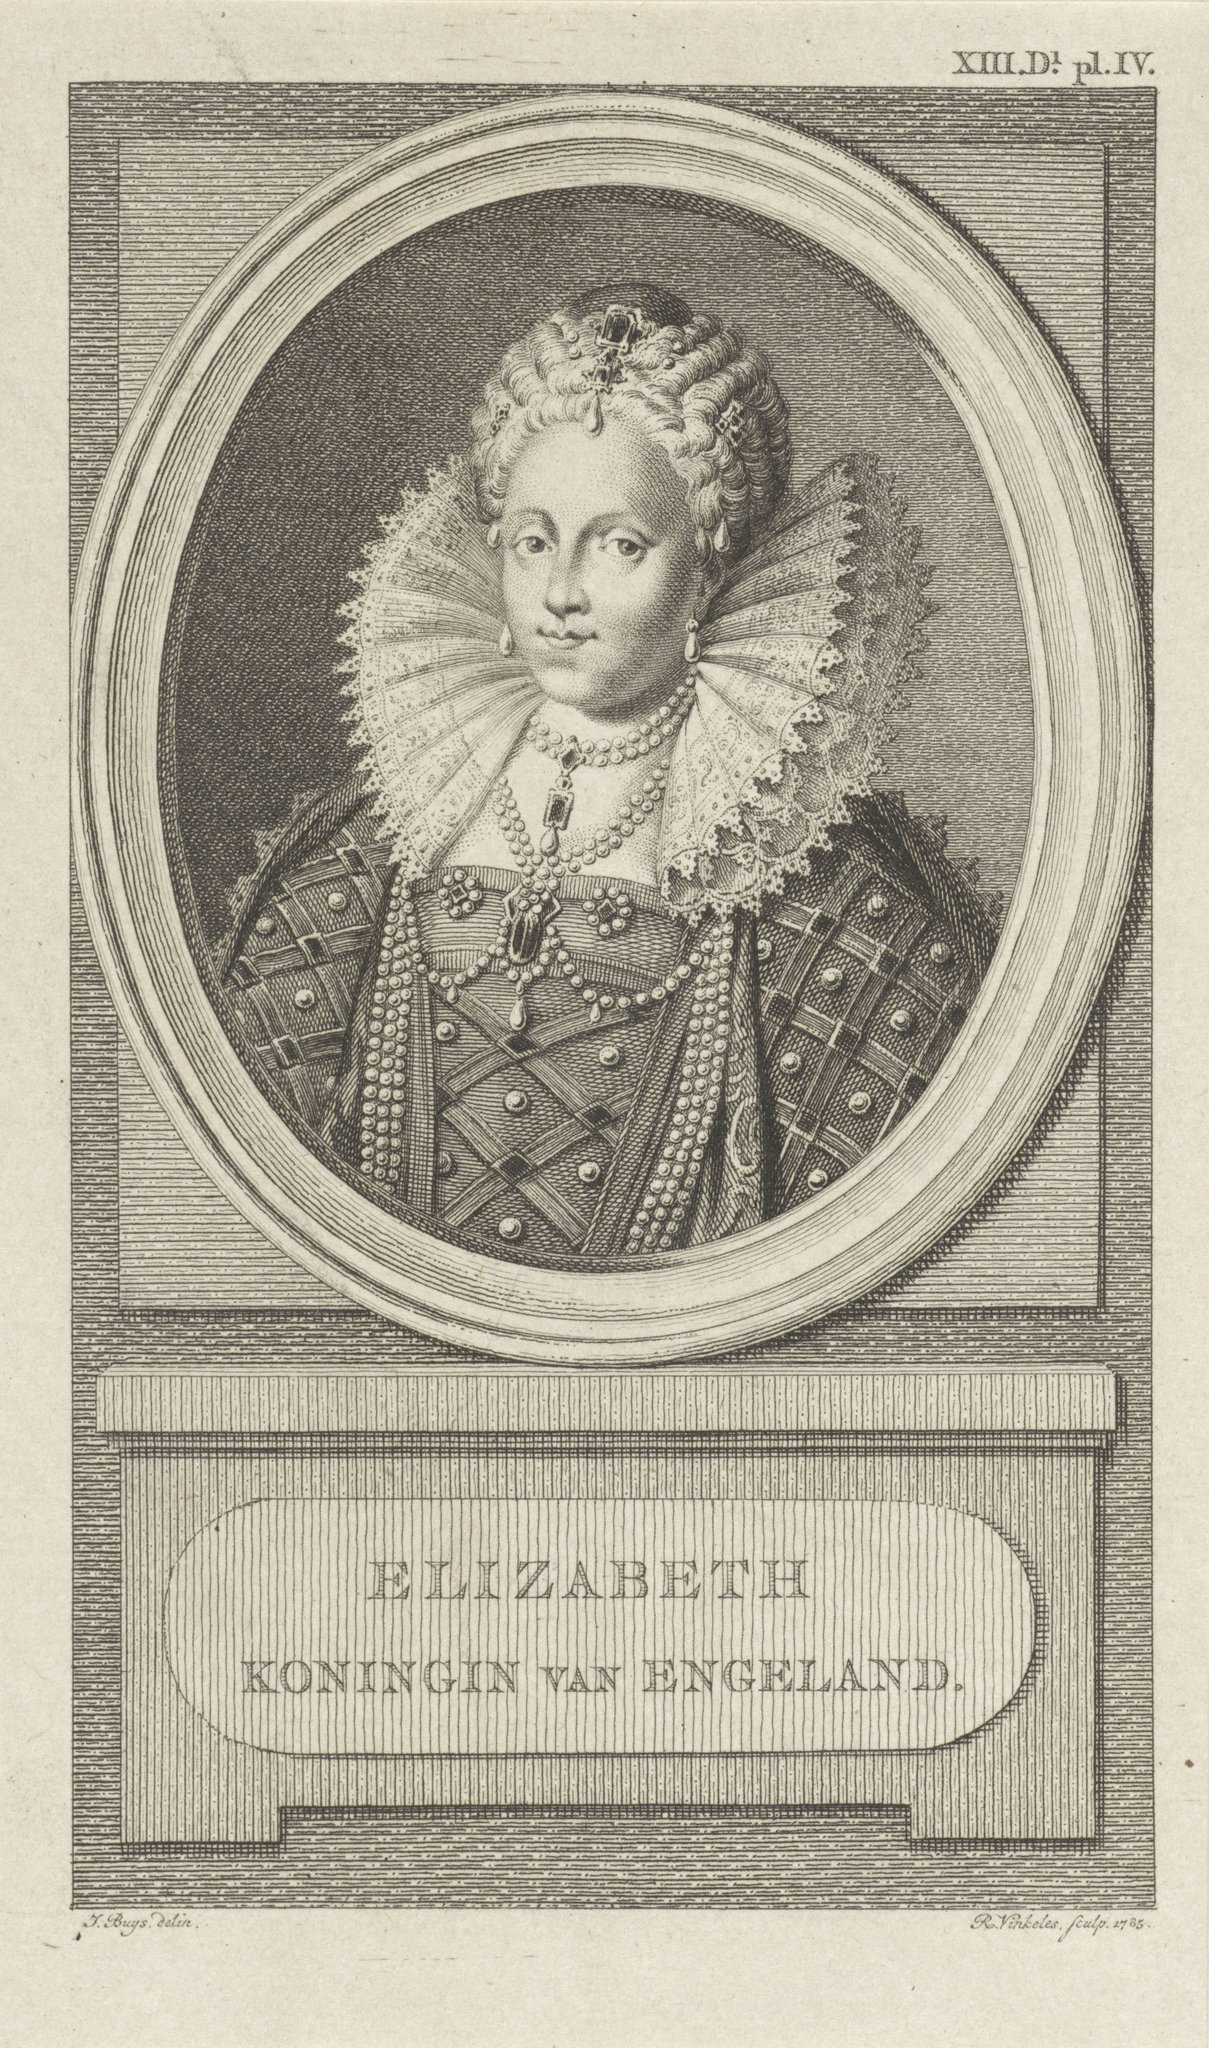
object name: print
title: Portret van Elizabeth I Tudor, koningin van Engeland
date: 1785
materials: paper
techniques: etching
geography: amsterdam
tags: greenwich, richmond (surrey), koningin, elizabeth i tudor (koningin van engeland)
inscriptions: collector's mark: Lugt 2228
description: Prent gebruikt als boekillustratie in: Kok, Jacobus. Vaderlandsch woordenboek : met kaarten, plaaten en pourtraitten. Amsterdam: Johannes Allart, 1785-1796. Deel XIII.